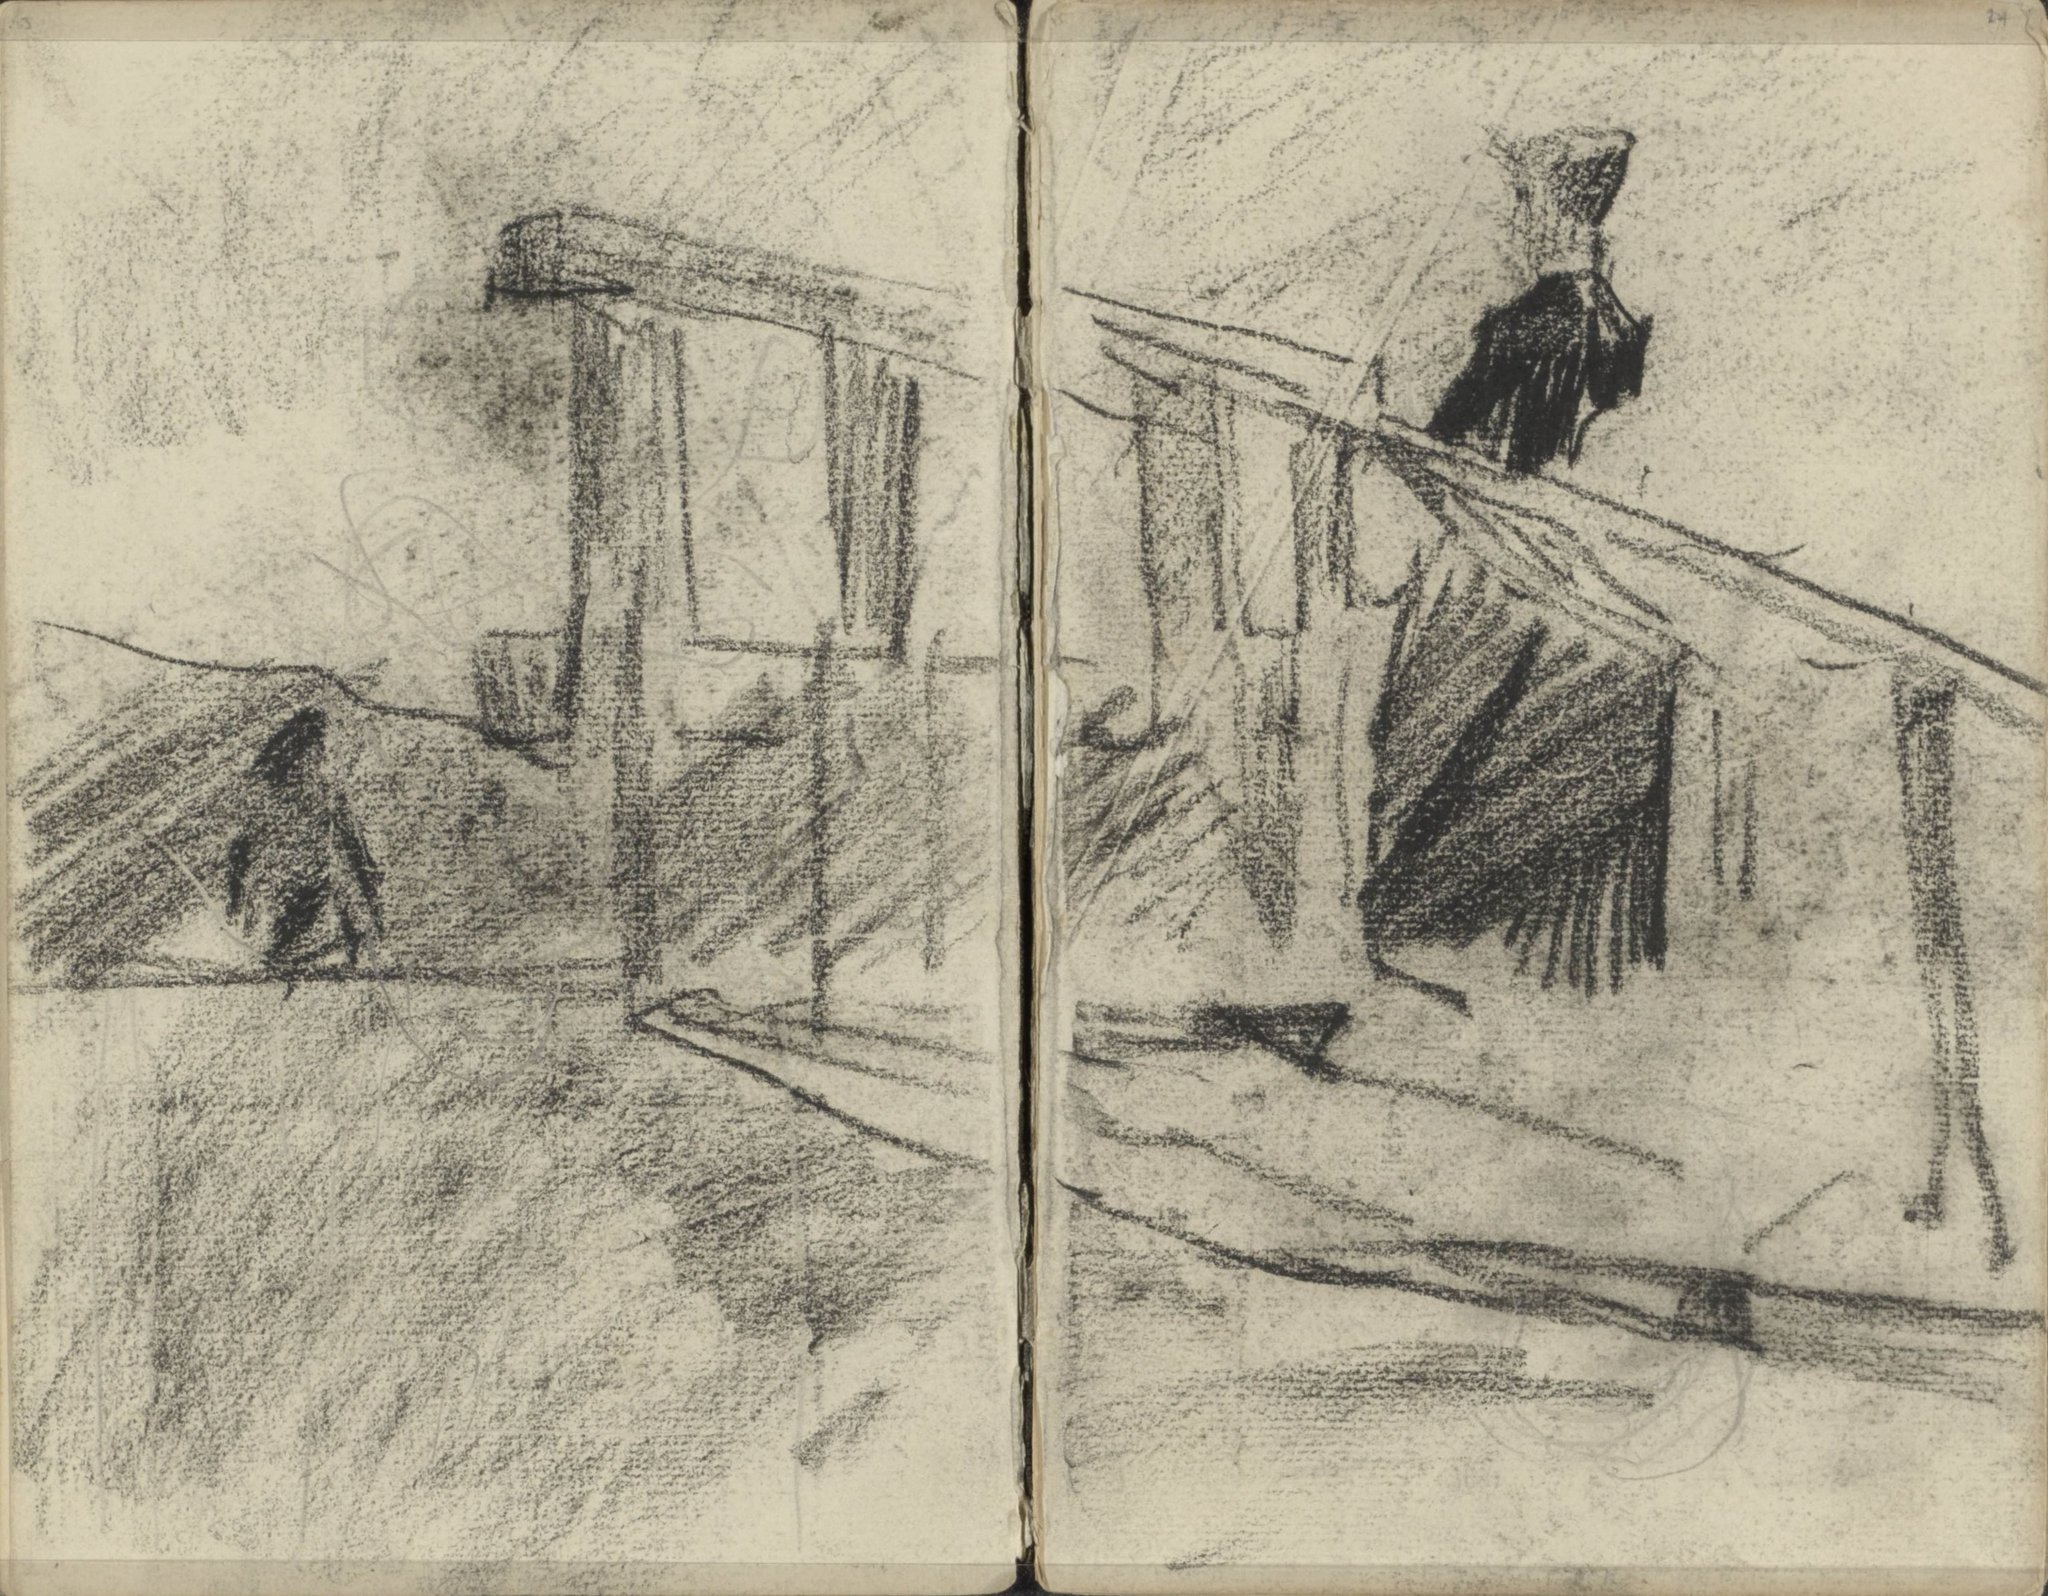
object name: sketchbook leaf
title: Vrouw, mogelijk op een brug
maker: george hendrik breitner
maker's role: draughtsman, painter, print maker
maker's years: 1857-1923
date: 1884-1886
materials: chalk, paper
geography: the hague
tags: bridge in city across river, canal, etc. (+ city(-scape) with figures, staffage), adult woman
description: Pagina 23 en pagina 24 uit een schetsboek met 19 bladen.